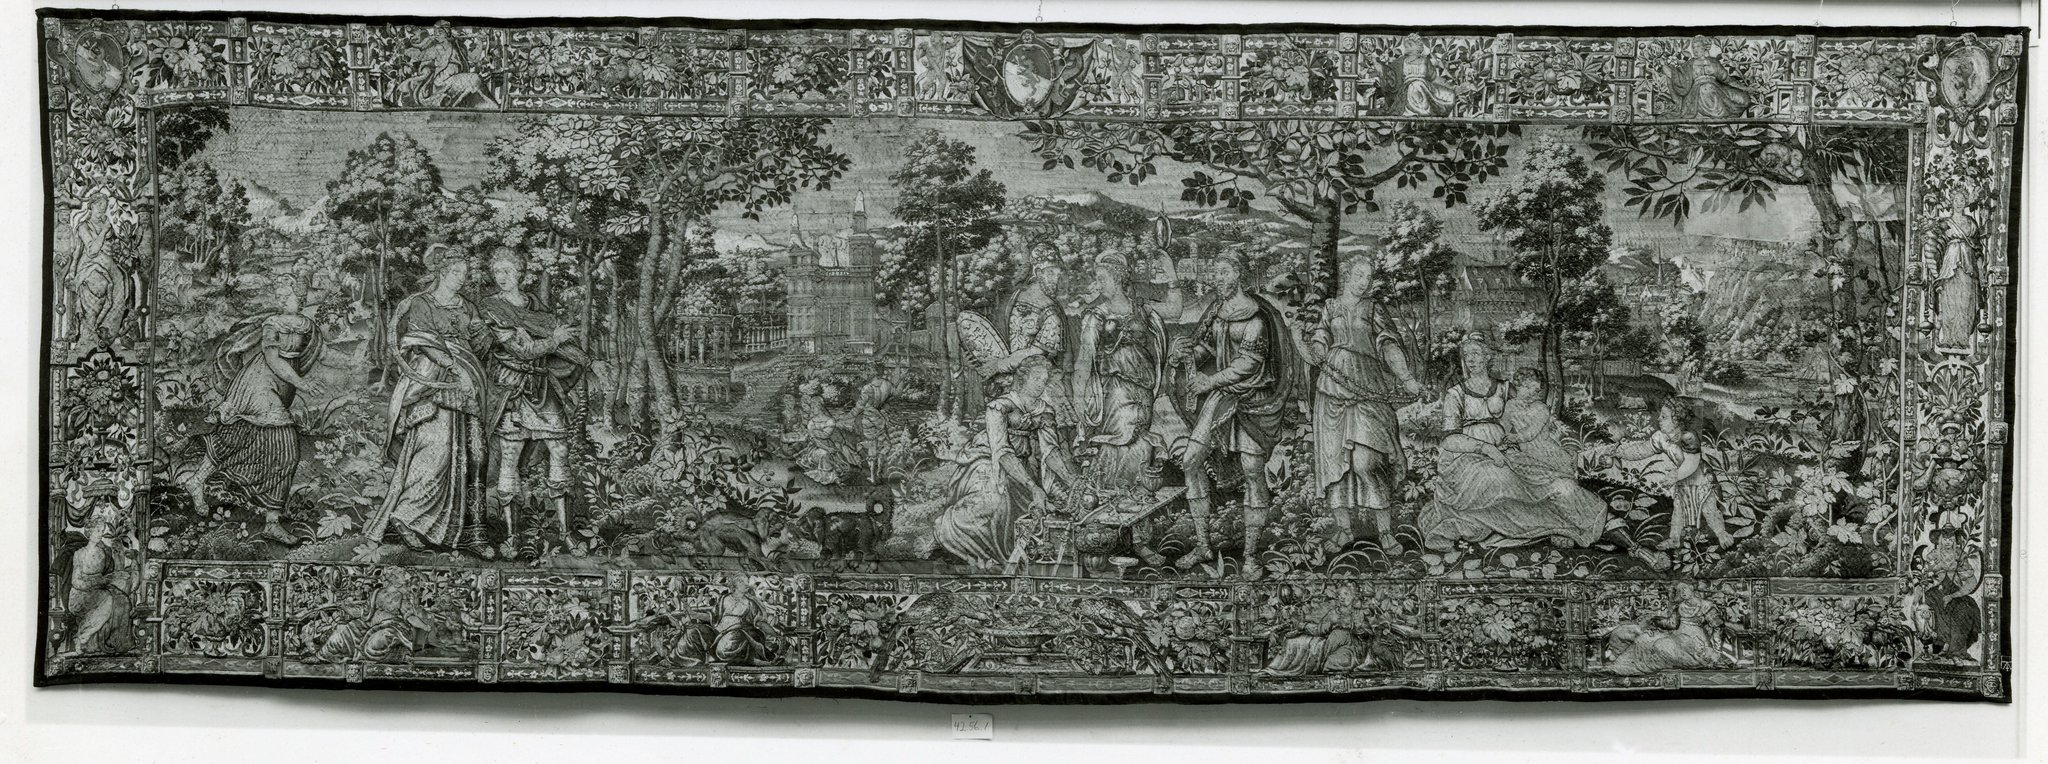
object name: tapestry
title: The Romans with their Sabine Wives from the Story of the Romans and the Sabines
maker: nicolas van orley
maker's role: designer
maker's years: 1540-1615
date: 1570-1585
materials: silk, wool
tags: buildings,men,women,plants